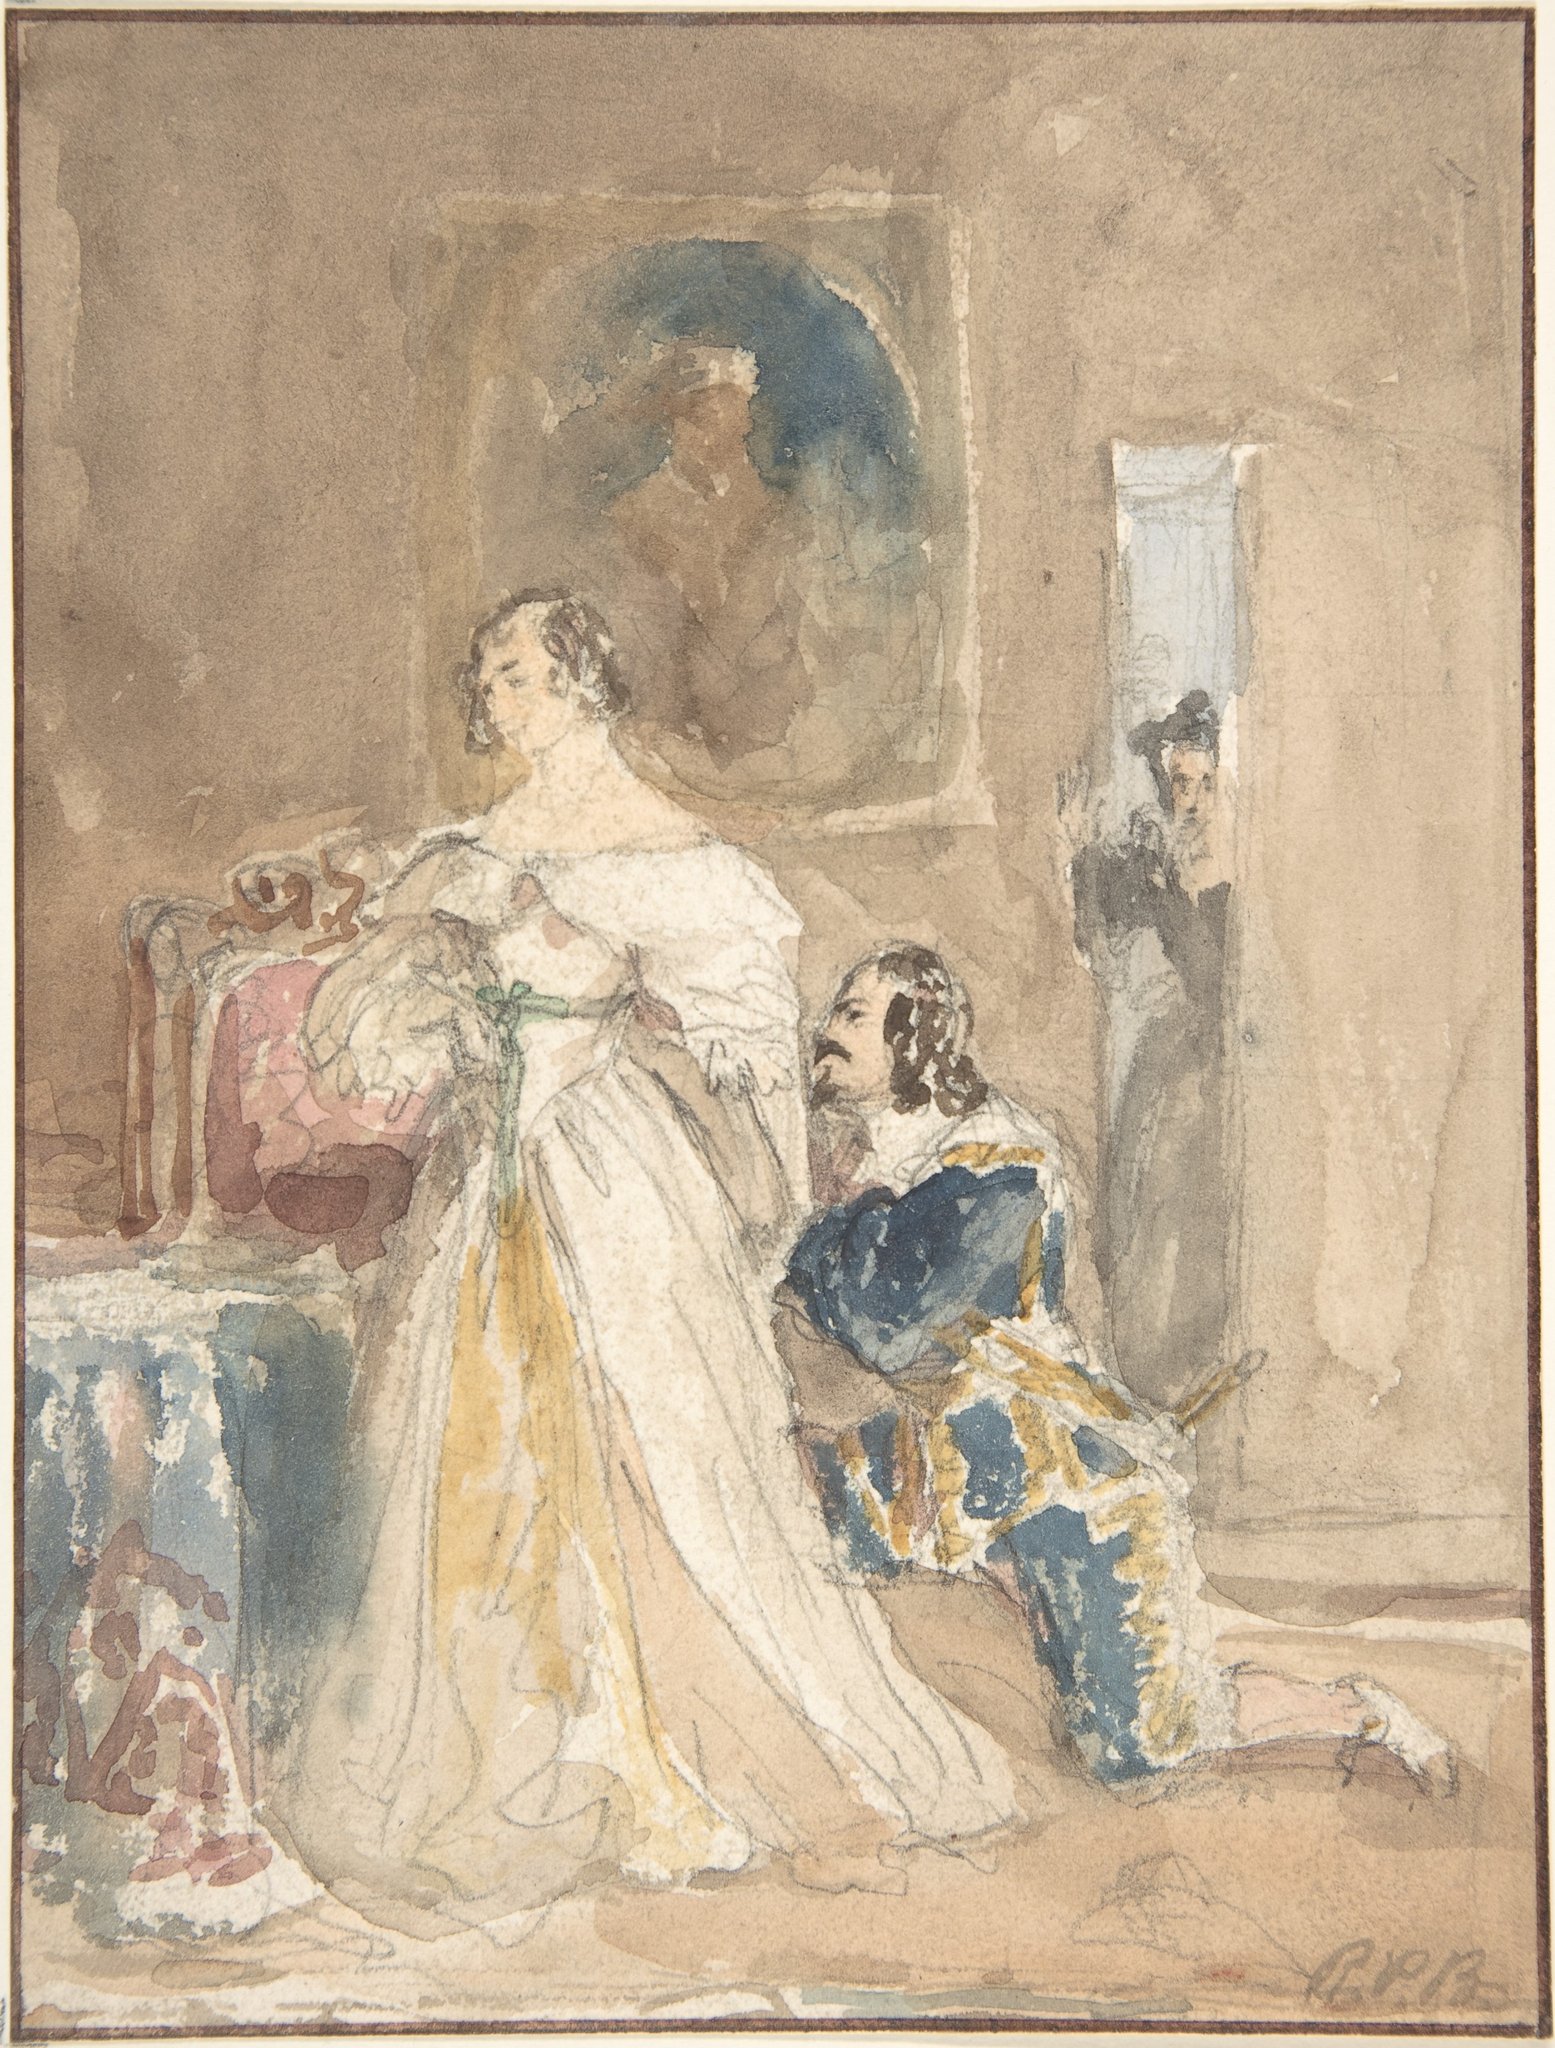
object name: drawing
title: The Proposal (recto); Unfinished drawing of a horse and rider (verso)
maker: richard parkes bonington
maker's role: artist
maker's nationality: british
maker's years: 1802-1828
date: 1820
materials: graphite, watercolor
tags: love,men,women